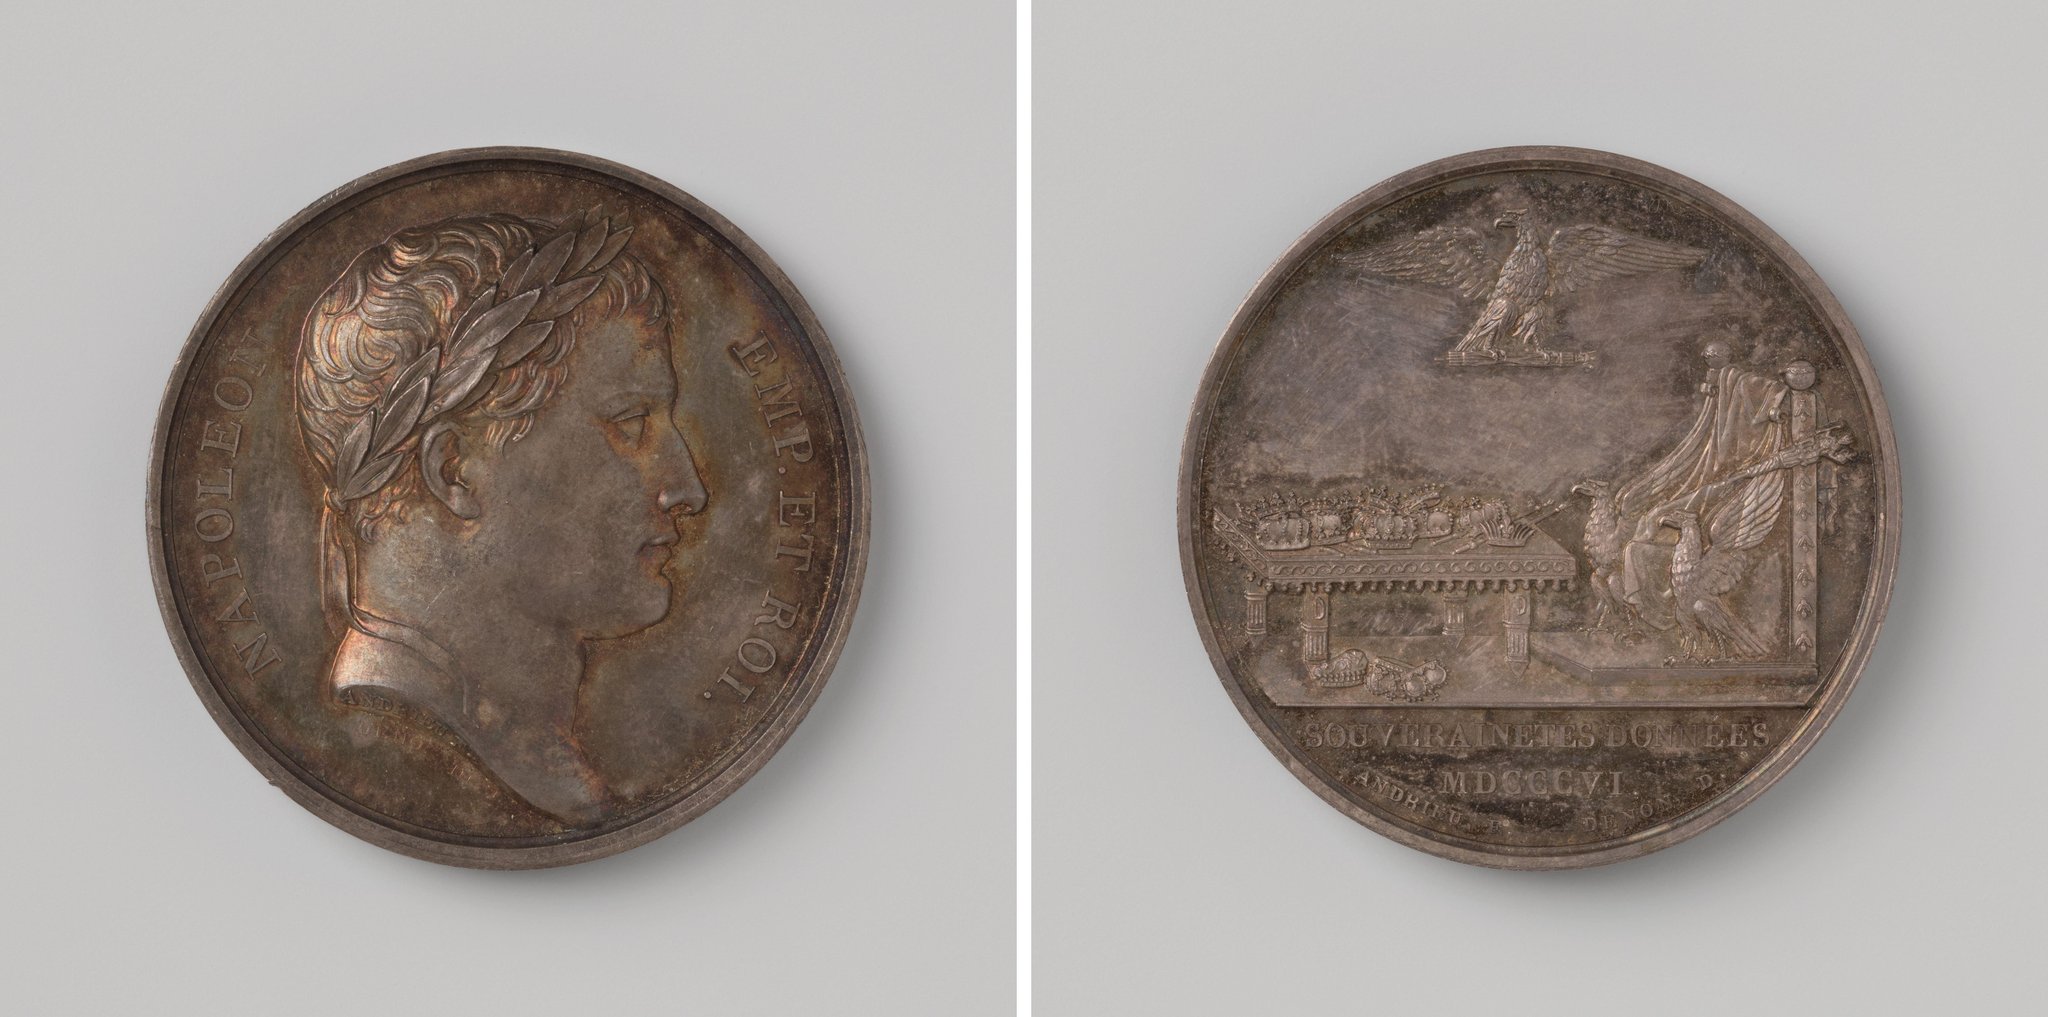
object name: history medal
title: Napoleon I Bonaparte stelt familieleden en vertrouwelingen aan als vorsten in de gebieden die onder Franse controle staan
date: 1806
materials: silver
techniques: striking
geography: paris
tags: louis napoleon (king of holland), napoleon i (emperor of the french), pizzo, eugène de beauharnais, politician, charles maurice hertog van talleyrand-périgord, netherlands, italy, cleves, naples